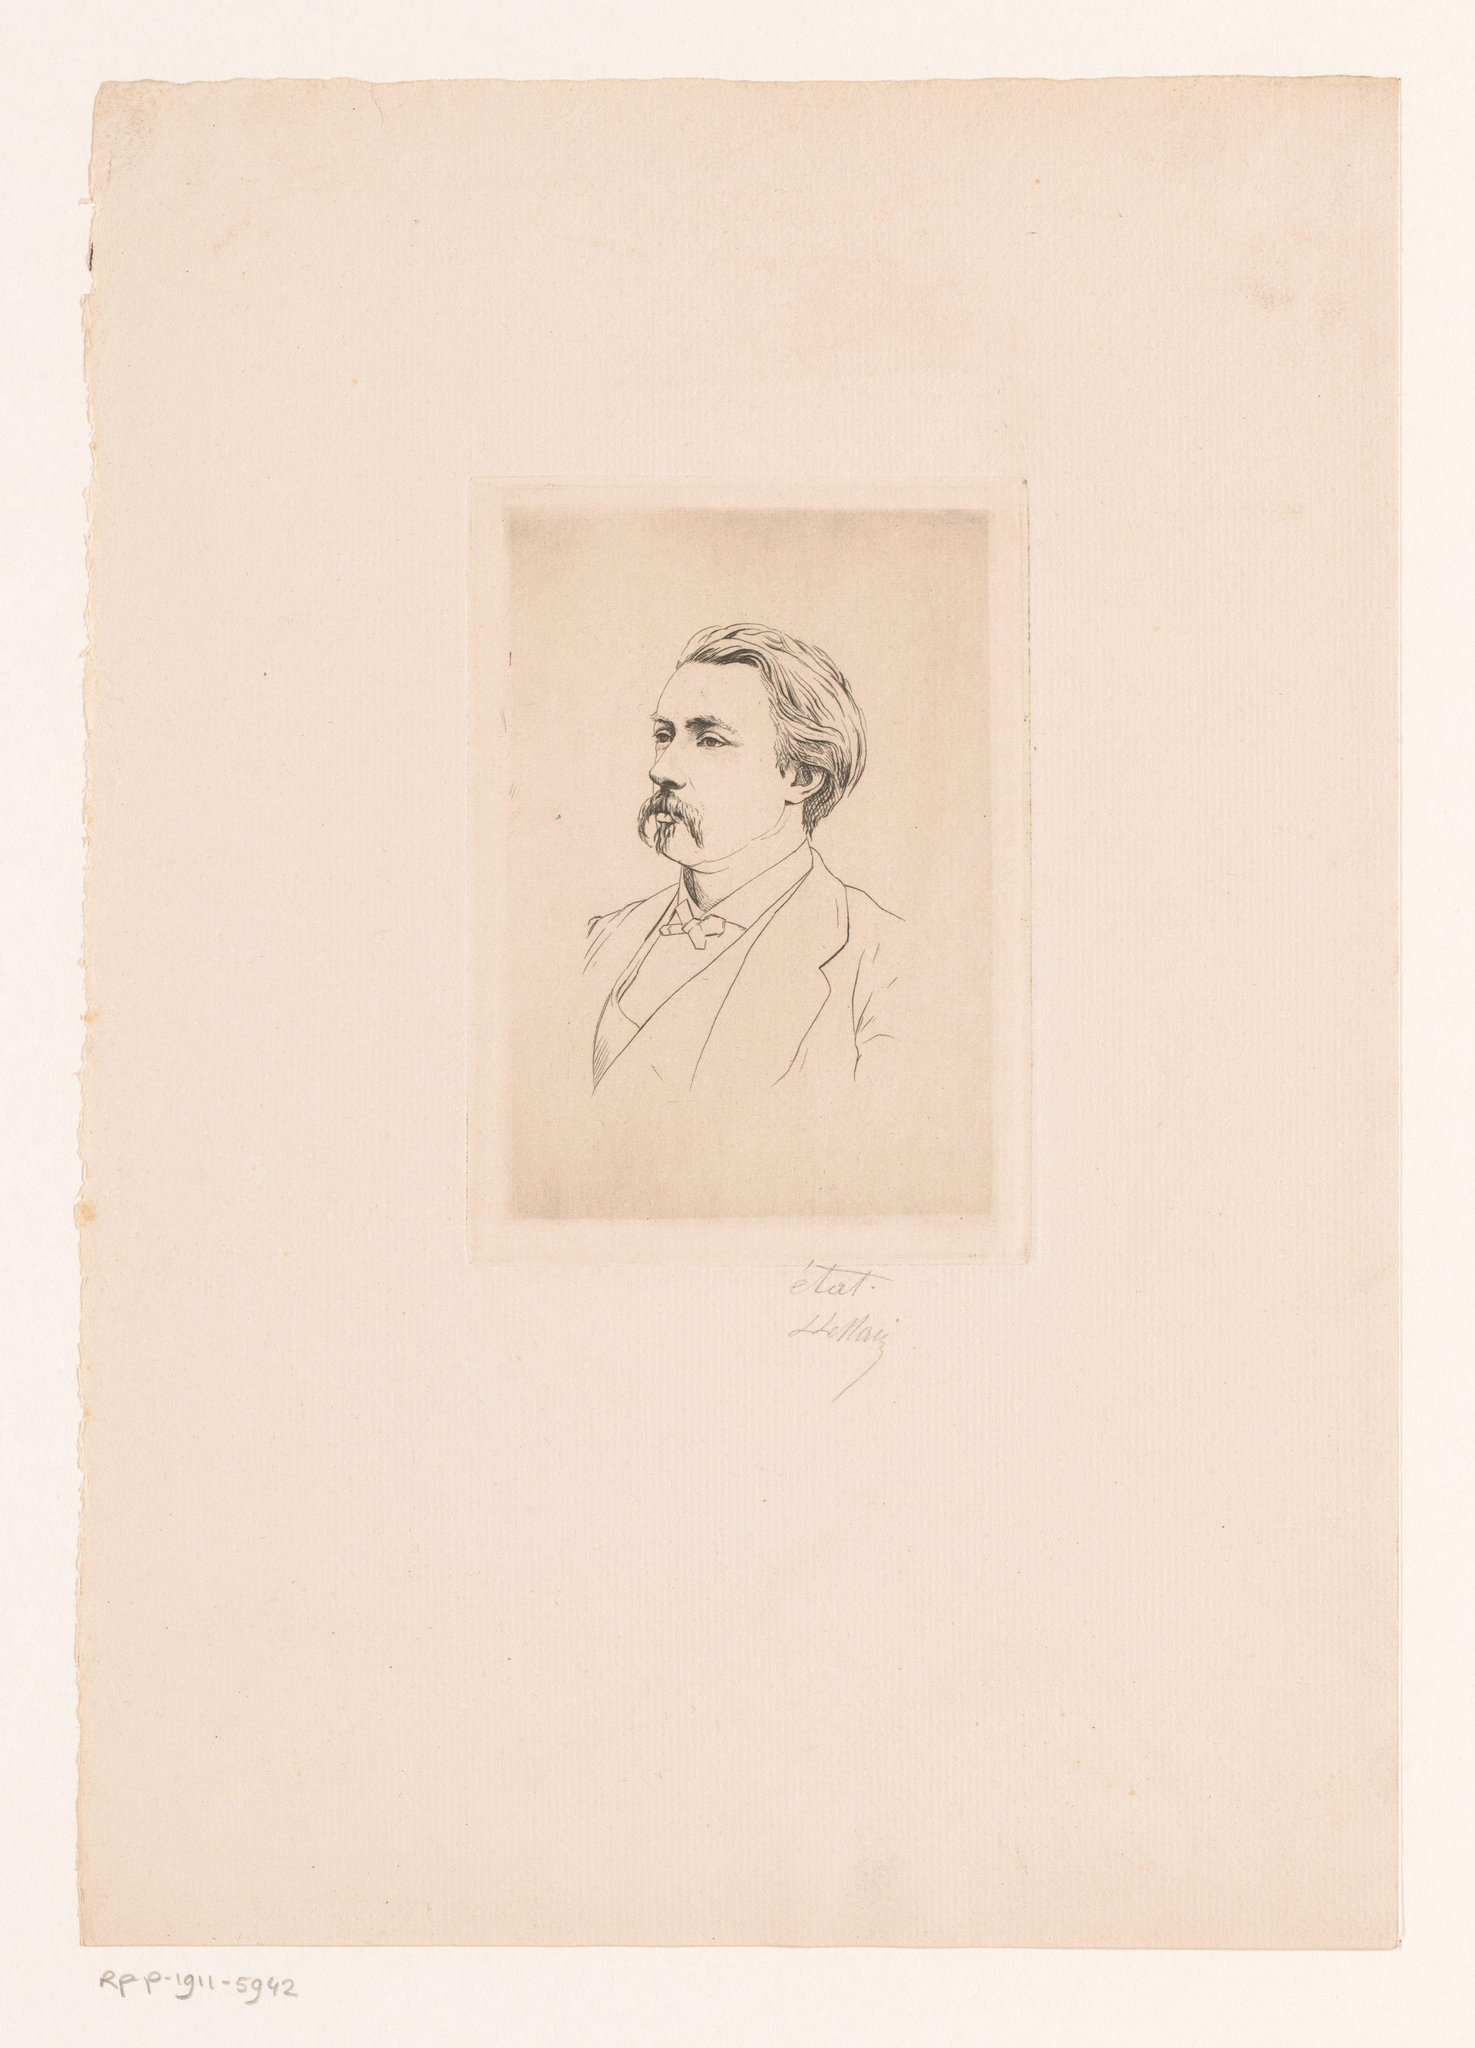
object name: print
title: Portret van een onbekende man, mogelijk F. Henne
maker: louis le nain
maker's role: print maker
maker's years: 1851-1939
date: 1861-1911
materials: paper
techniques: etching, intaglio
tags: moustache, adult man, historical persons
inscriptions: collector's mark: Lugt 2228, inscription: ‘État LLeNain’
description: Opschrift op object in potlood: F. Henne.